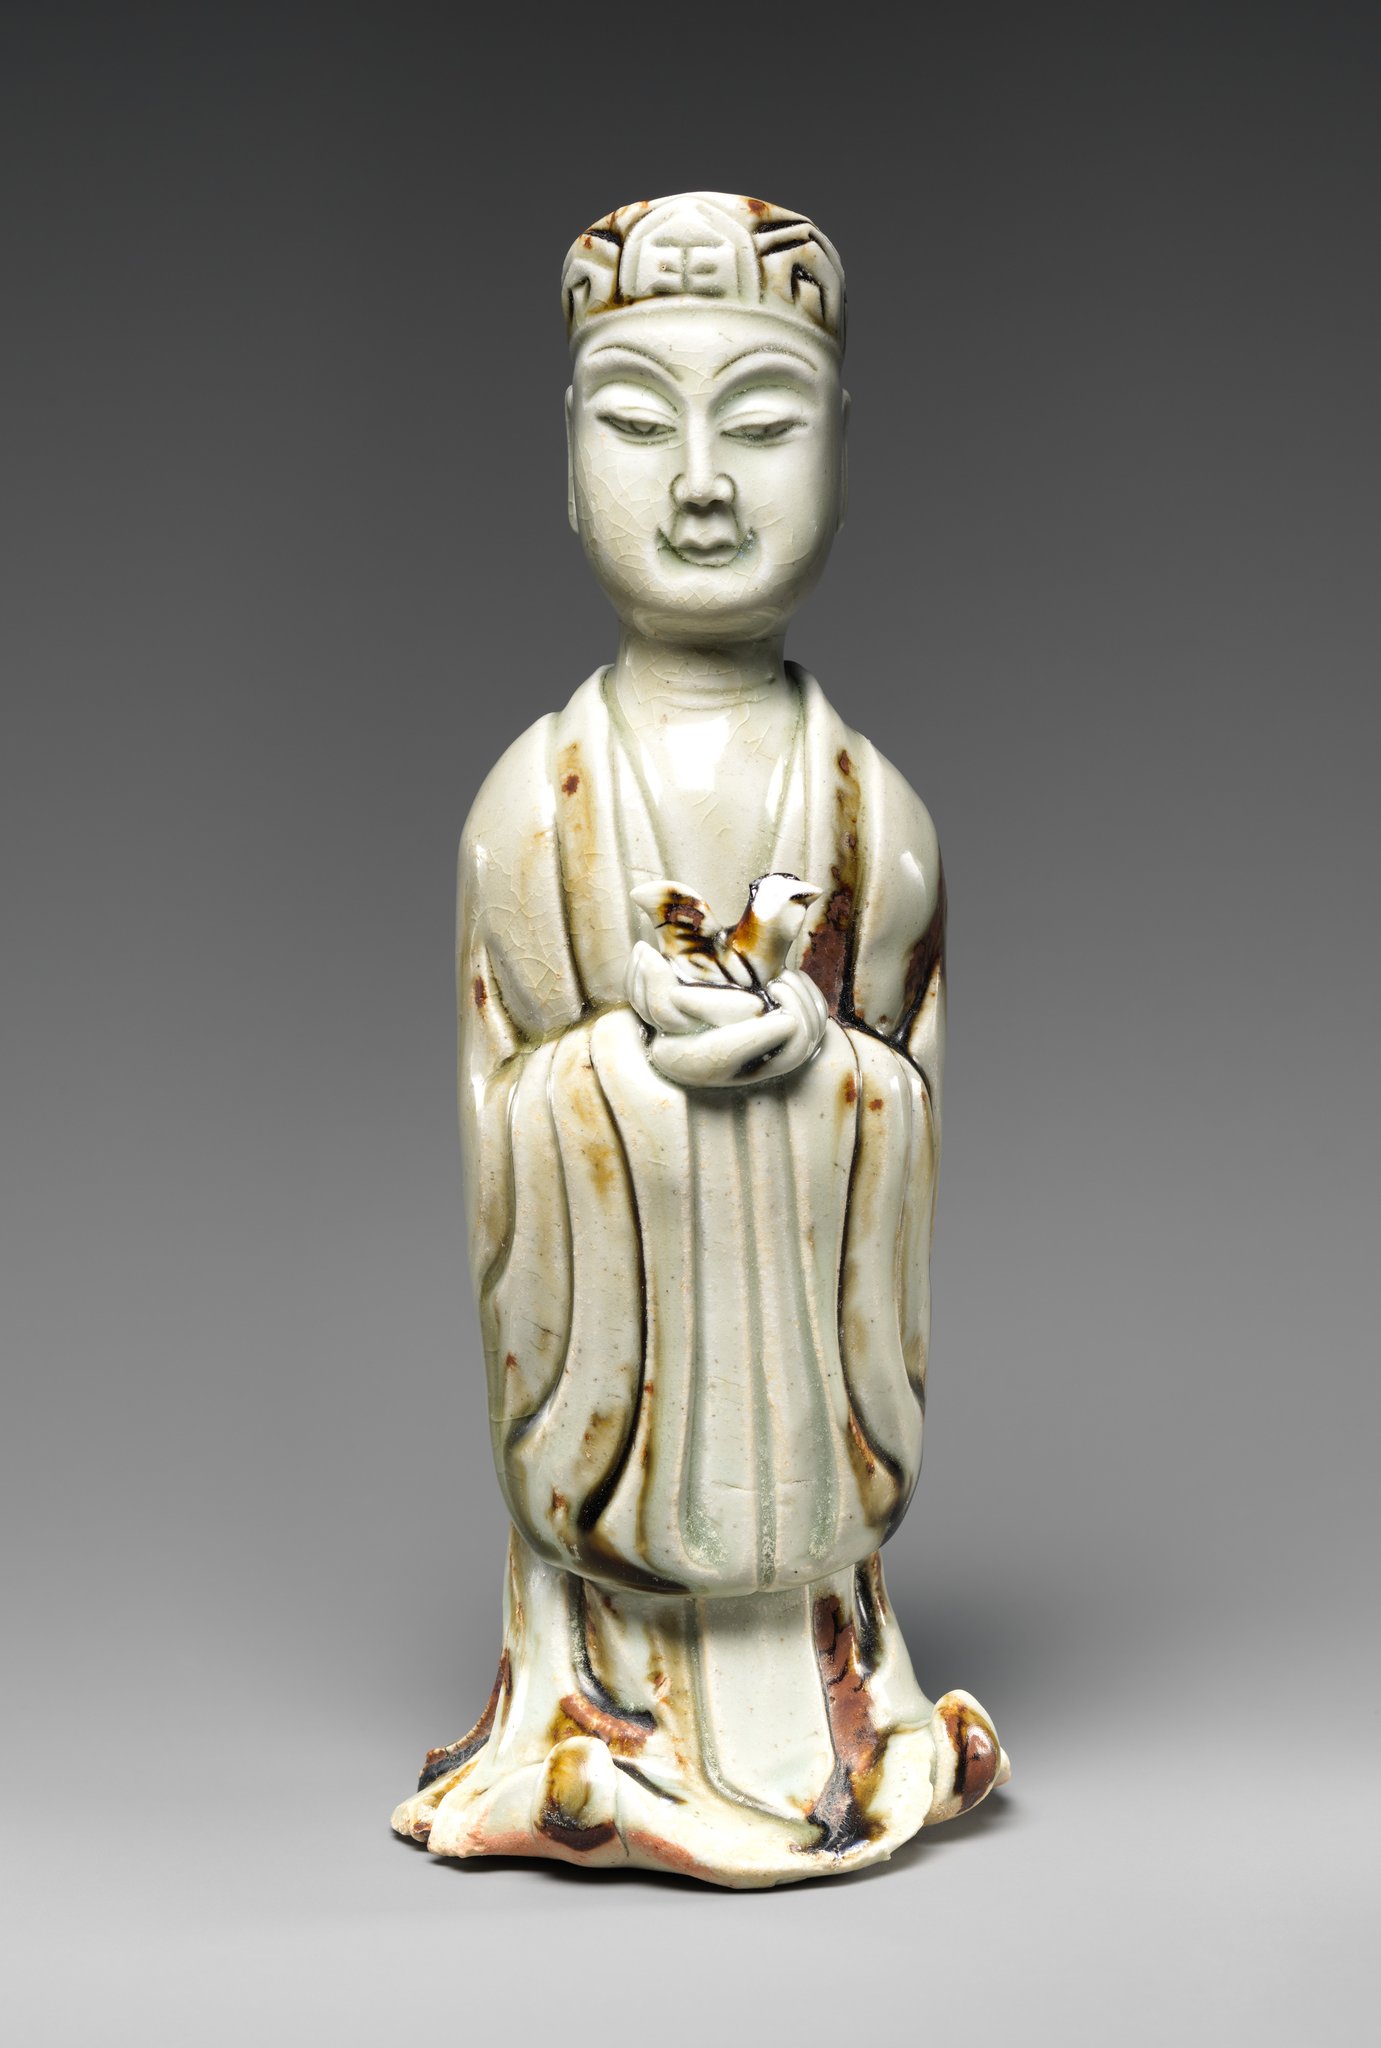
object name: figure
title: Daoist Priest with Zodiac Animal, Rooster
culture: chinese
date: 960-1279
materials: stoneware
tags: men